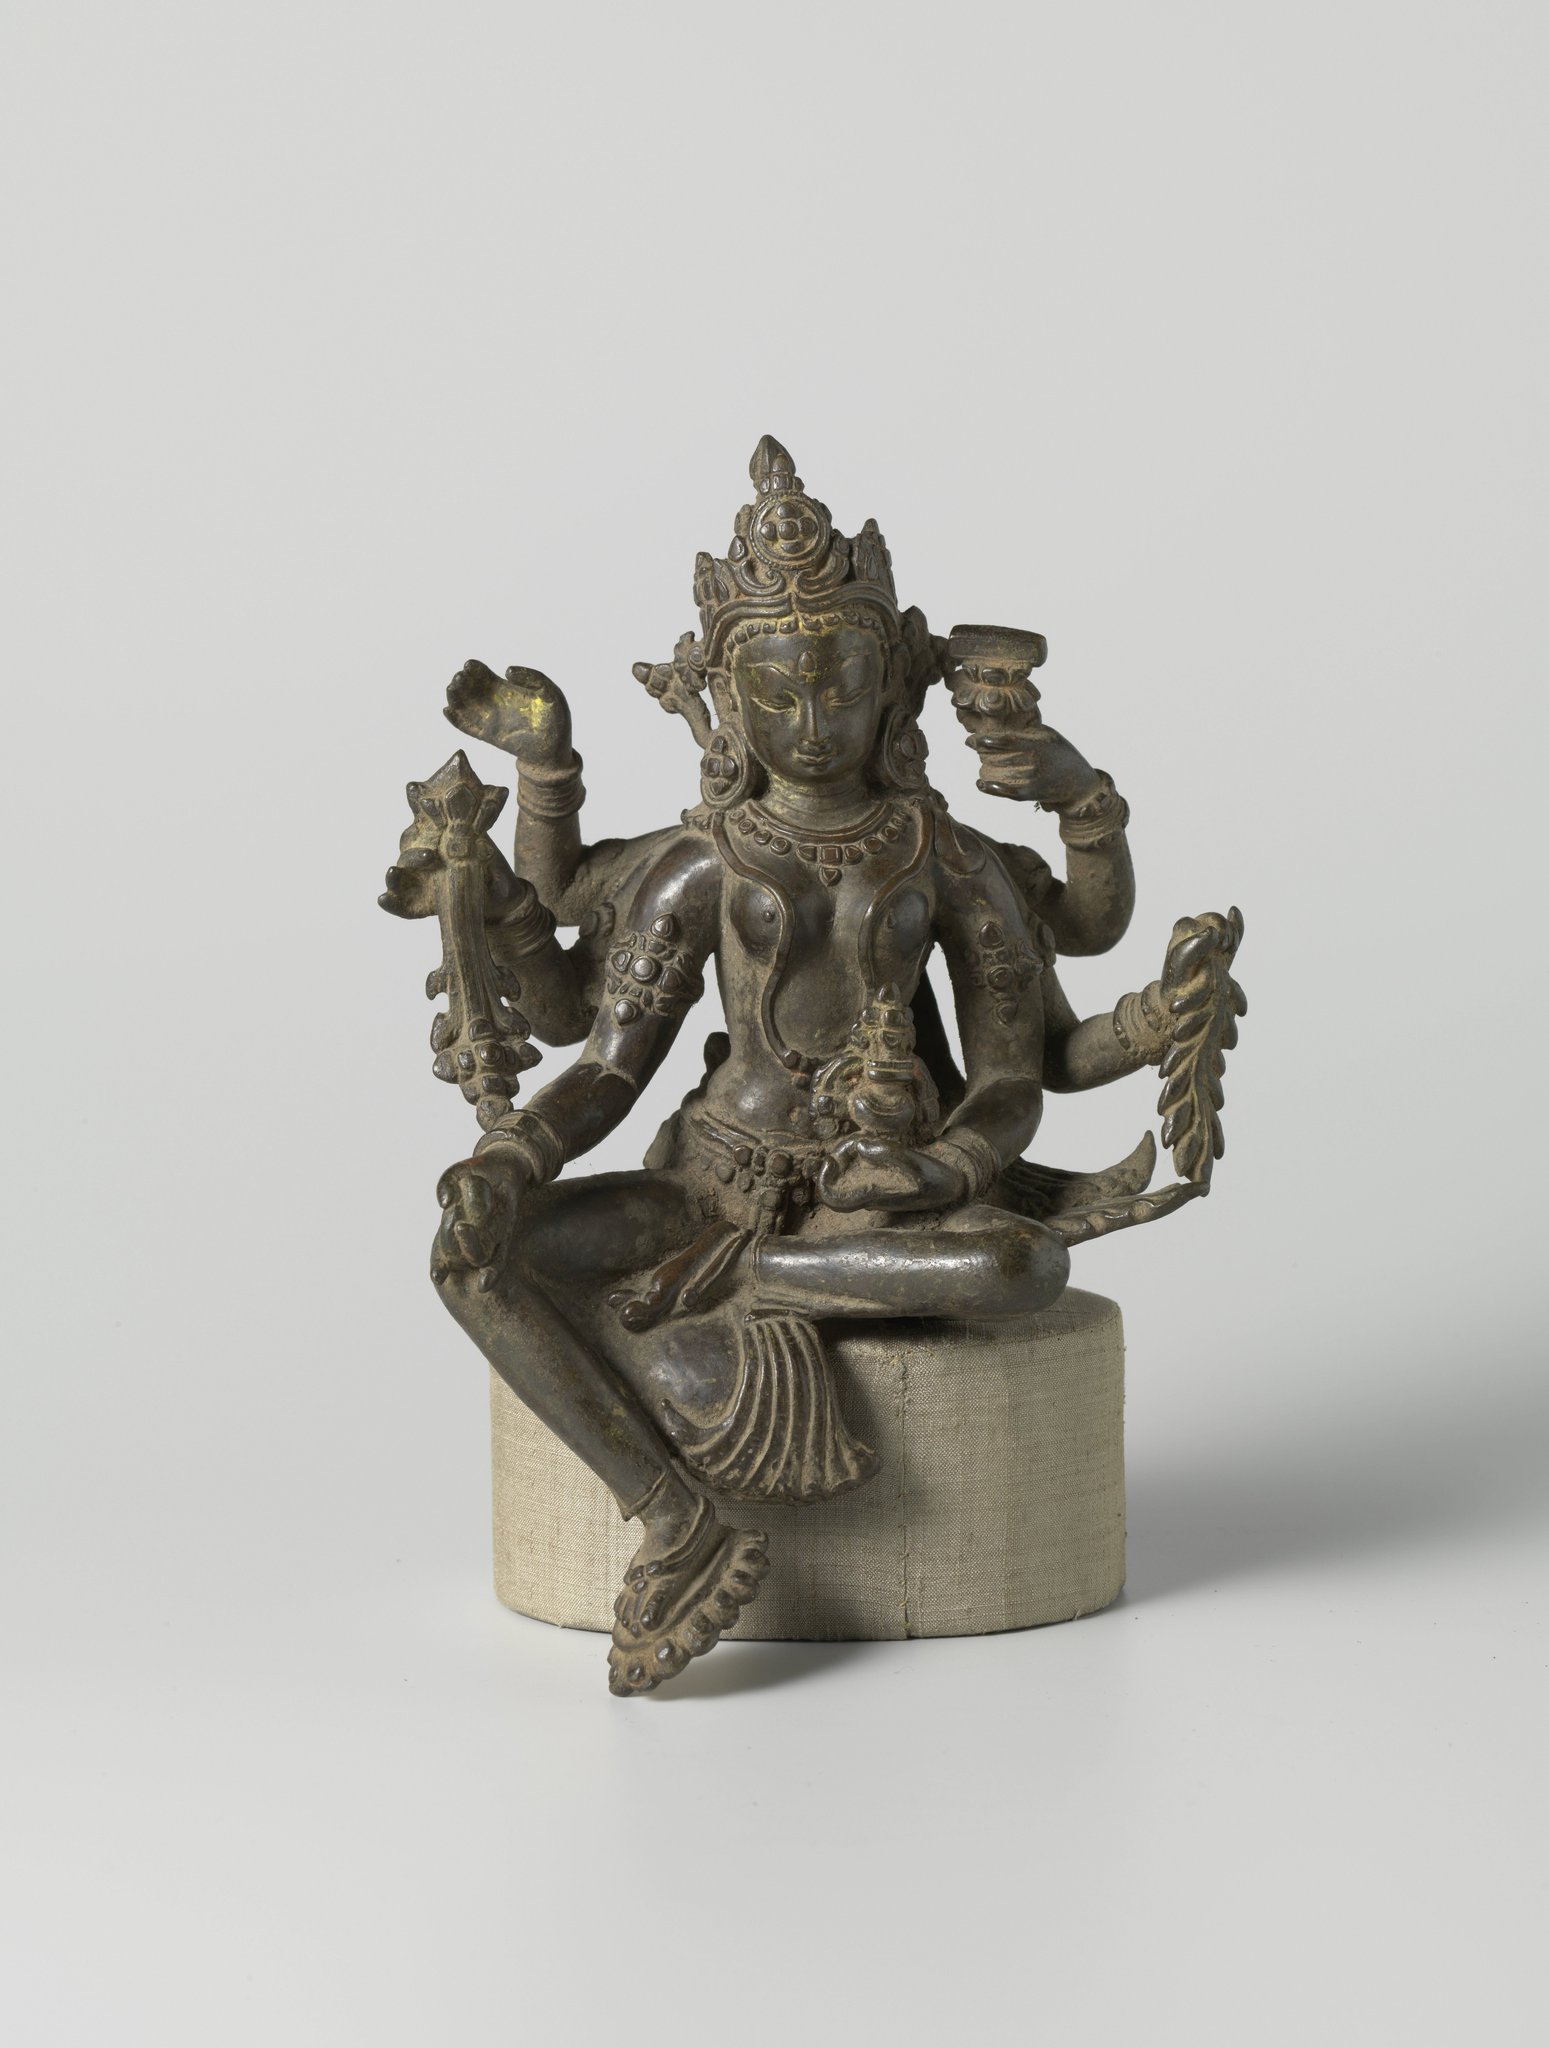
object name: figure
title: Vasudhara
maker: Anonymous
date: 1500-1600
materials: bronze, dye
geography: nepal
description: Vasudhara, zes armig. Brons met sporen van polychromie. Op sokkel.